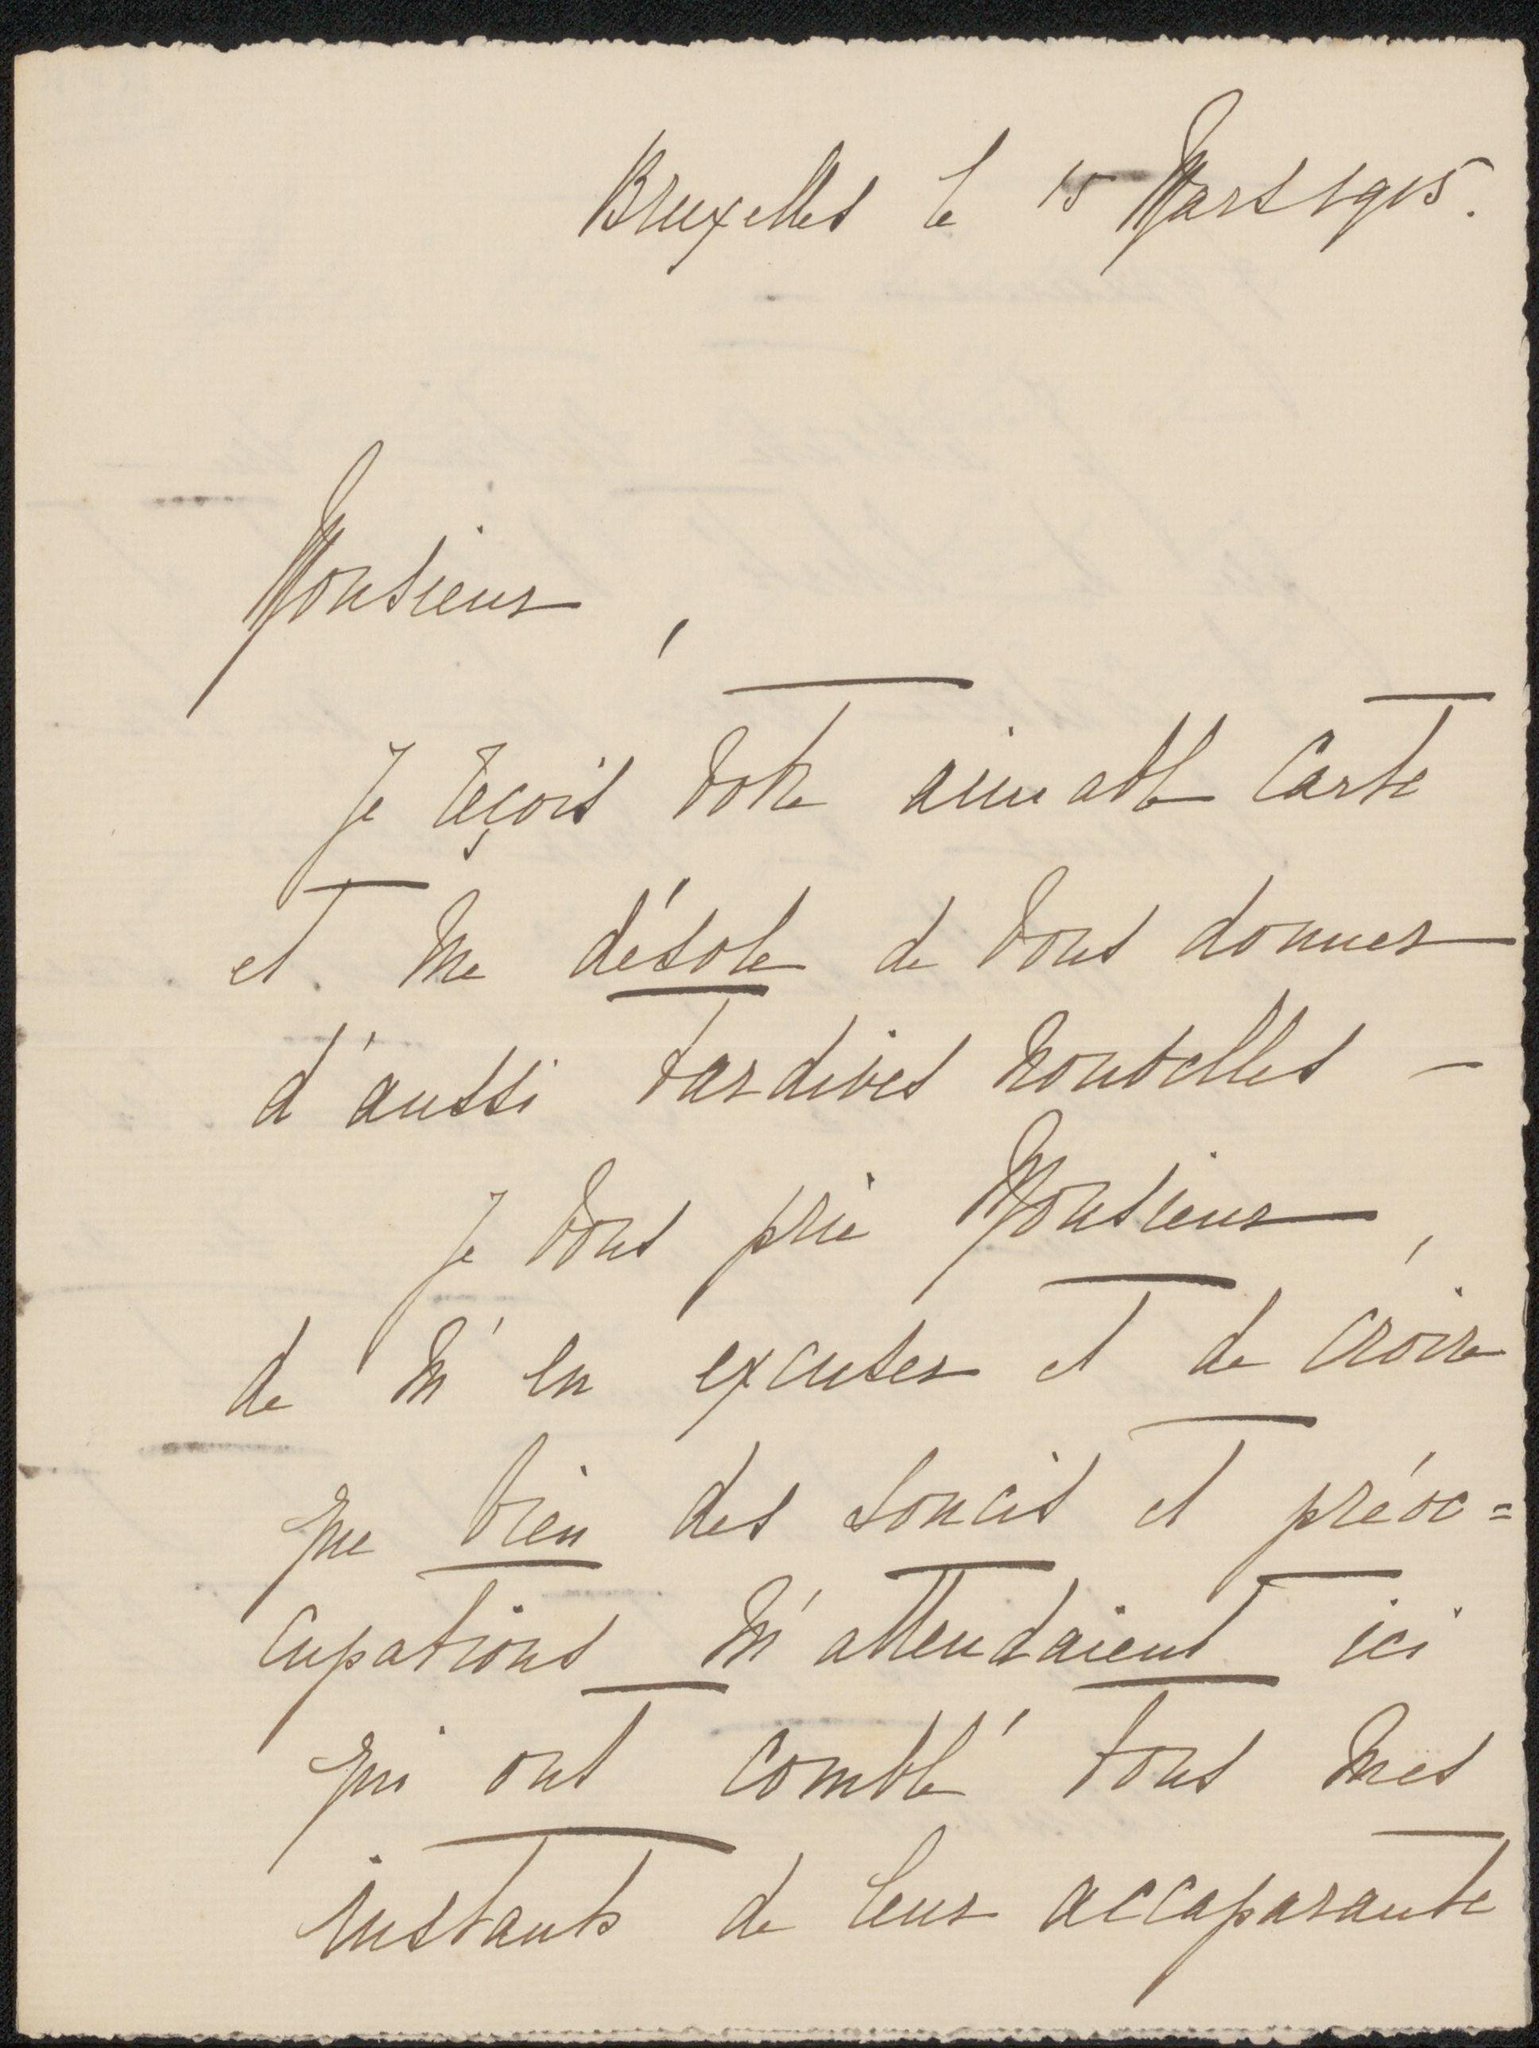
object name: letter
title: Brief aan Philip Zilcken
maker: germaine wenziner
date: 1915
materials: ink, paper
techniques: pen, writing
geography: brussels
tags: painter, draughtsman, philip zilcken, netherlands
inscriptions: collector's mark: ‘RPK’